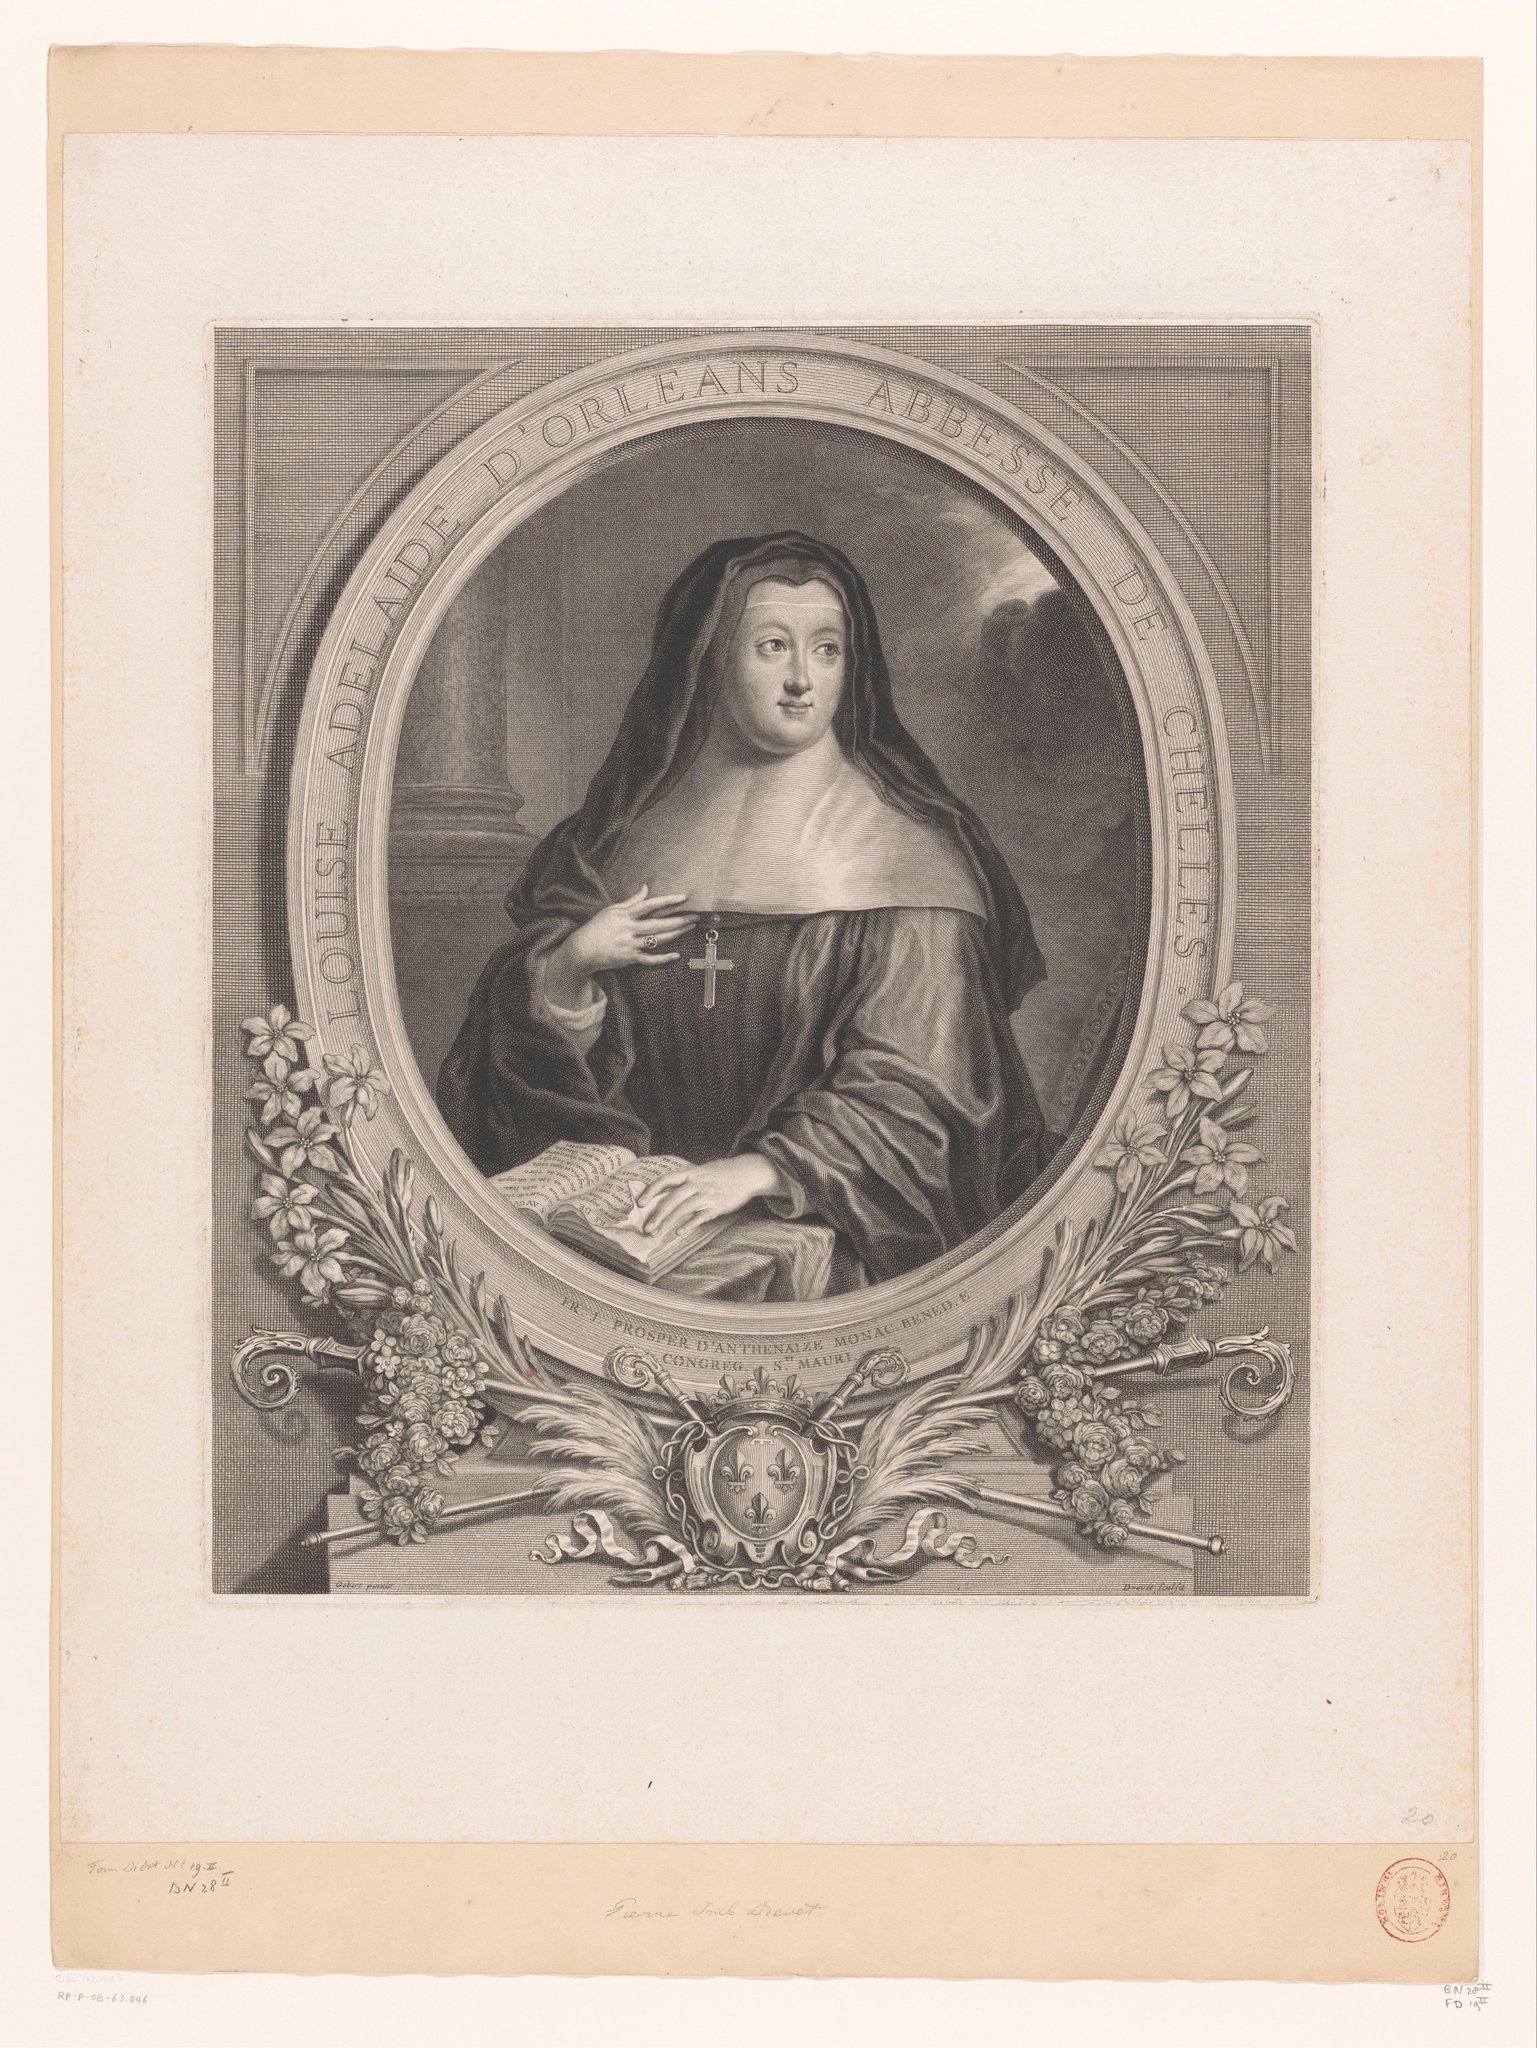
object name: print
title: Portret van Louise Adélaïde van Orléans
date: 1719-1726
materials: paper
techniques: engraving, etching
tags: paris, historical persons - bb - woman, armorial bearing, heraldry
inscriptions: collector's mark: Lugt 240